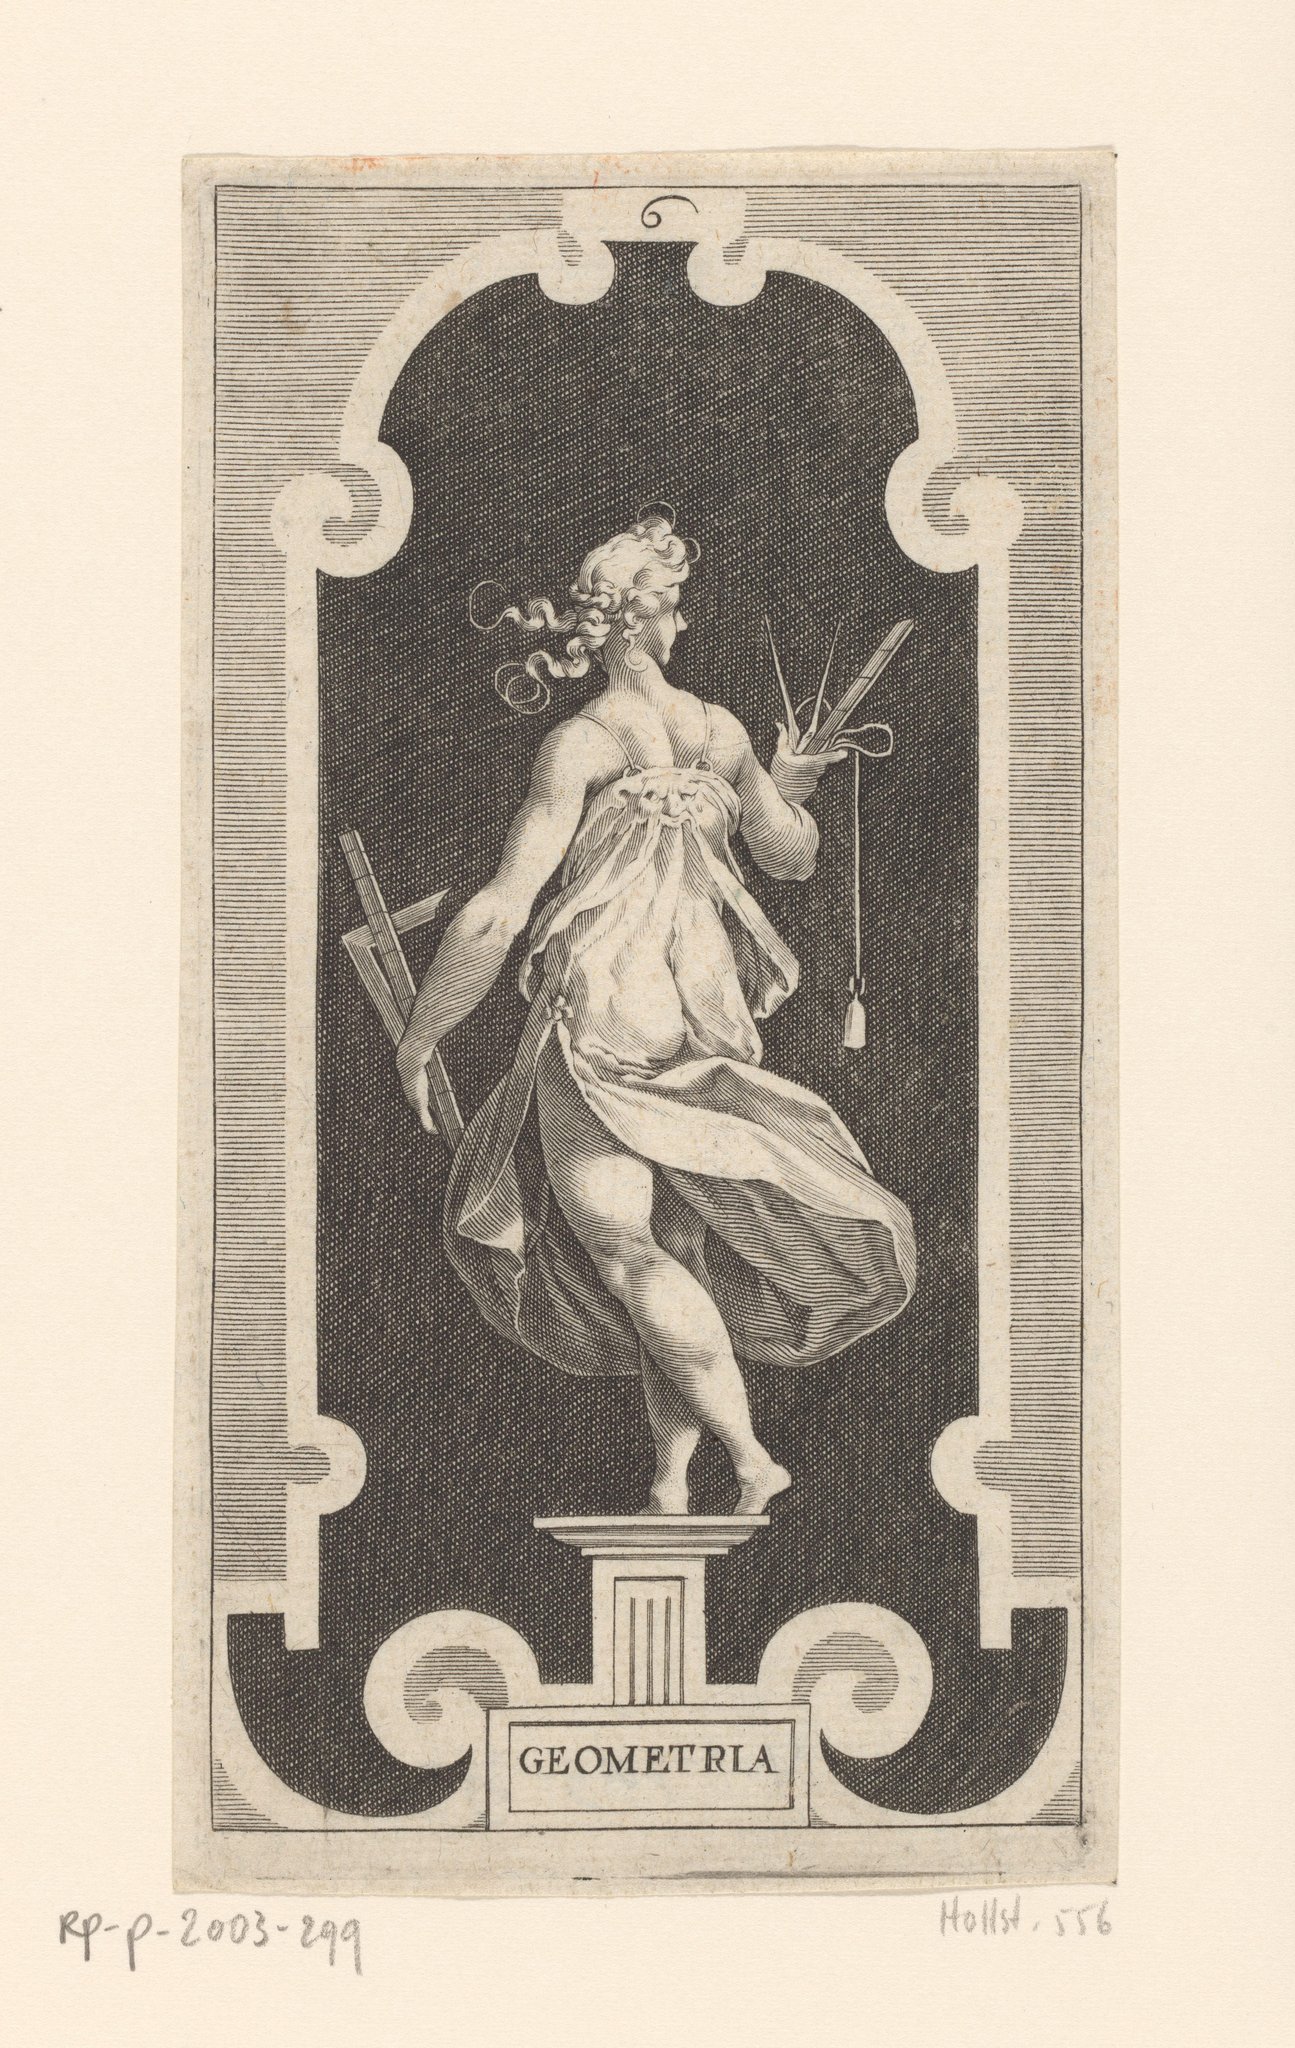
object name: print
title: Personificatie van Geometrie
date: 1640-1708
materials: paper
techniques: engraving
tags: the liberal arts, 'artes liberales', 'geometria' (~ quadrivium); 'geometria' (ripa), measuring-instruments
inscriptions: collector's mark: Lugt 2228, collector's mark: Lugt 2760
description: Deze prent hoort bij een serie van zeven prenten met personificaties van Zeven Vrij Kunsten.